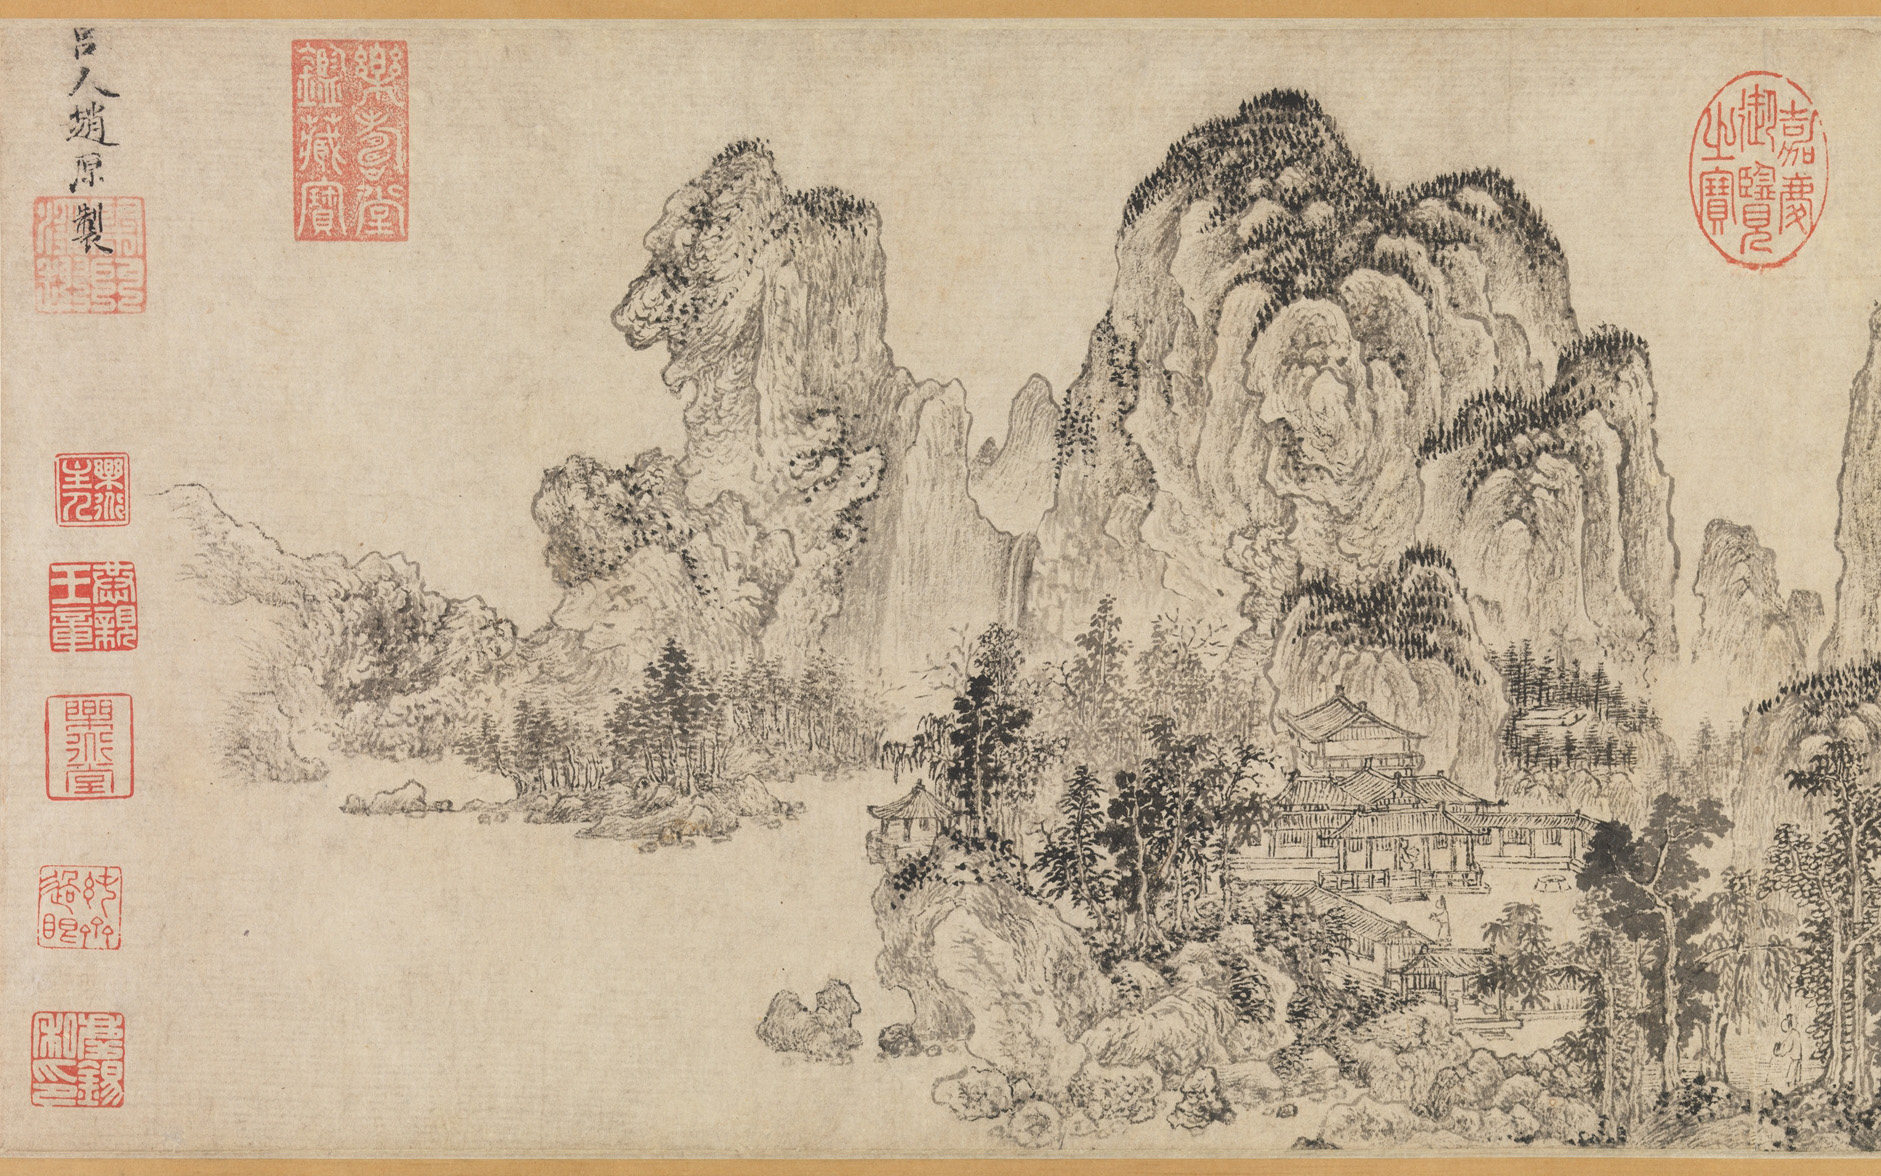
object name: handscroll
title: Landscape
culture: chinese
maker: zhao yuan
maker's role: artist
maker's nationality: chinese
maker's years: 1350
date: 1367-1400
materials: ink, paper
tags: mountains,landscapes